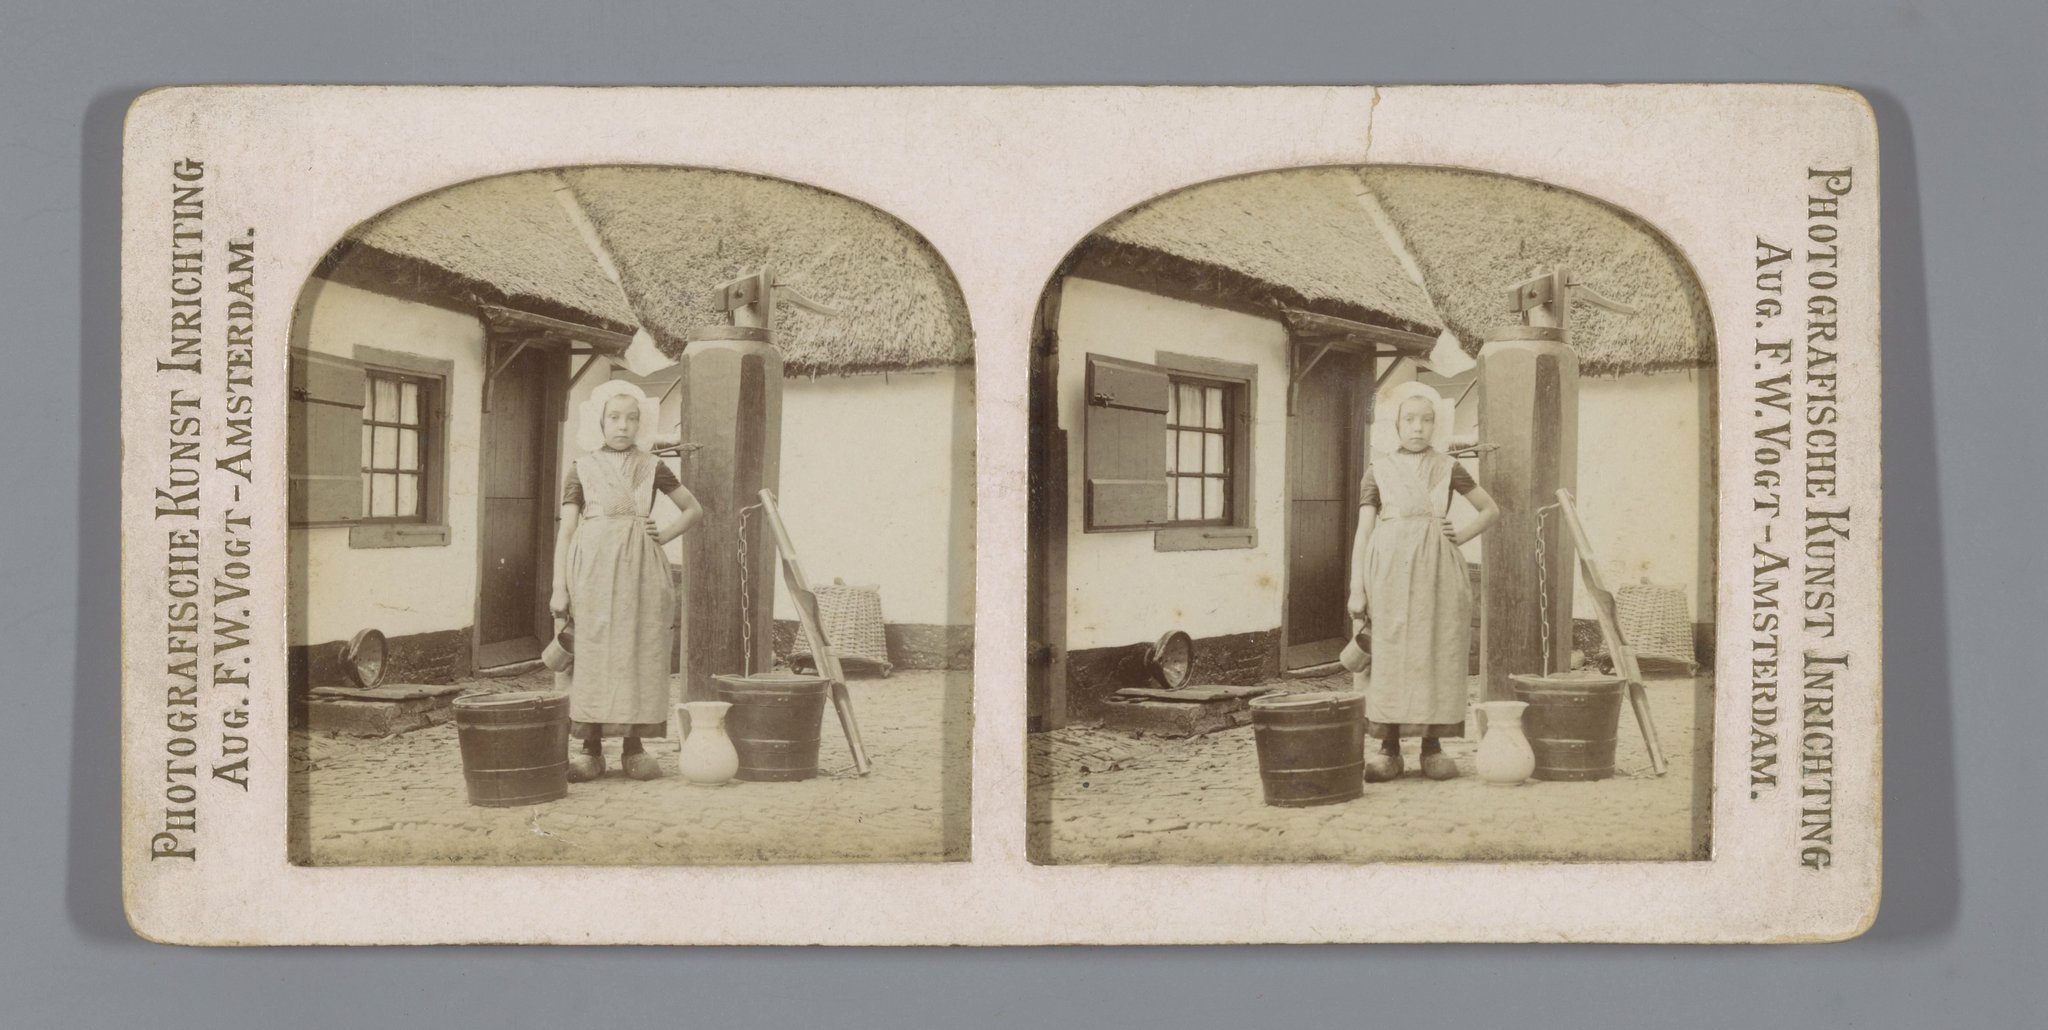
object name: tissue stereograph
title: Meisje in klederdracht naast waterpomp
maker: august frederik willem vogt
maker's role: fotograaf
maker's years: 1871-1922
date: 1897-1922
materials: cardboard, paper, photographic support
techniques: albumen print, hand coloring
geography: amsterdam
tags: child (at home) - aa - girl, utilitarian, public pump or water fountain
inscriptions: number: ‘5127’, inscription: ‘Photografische Kunst-Inrichting’